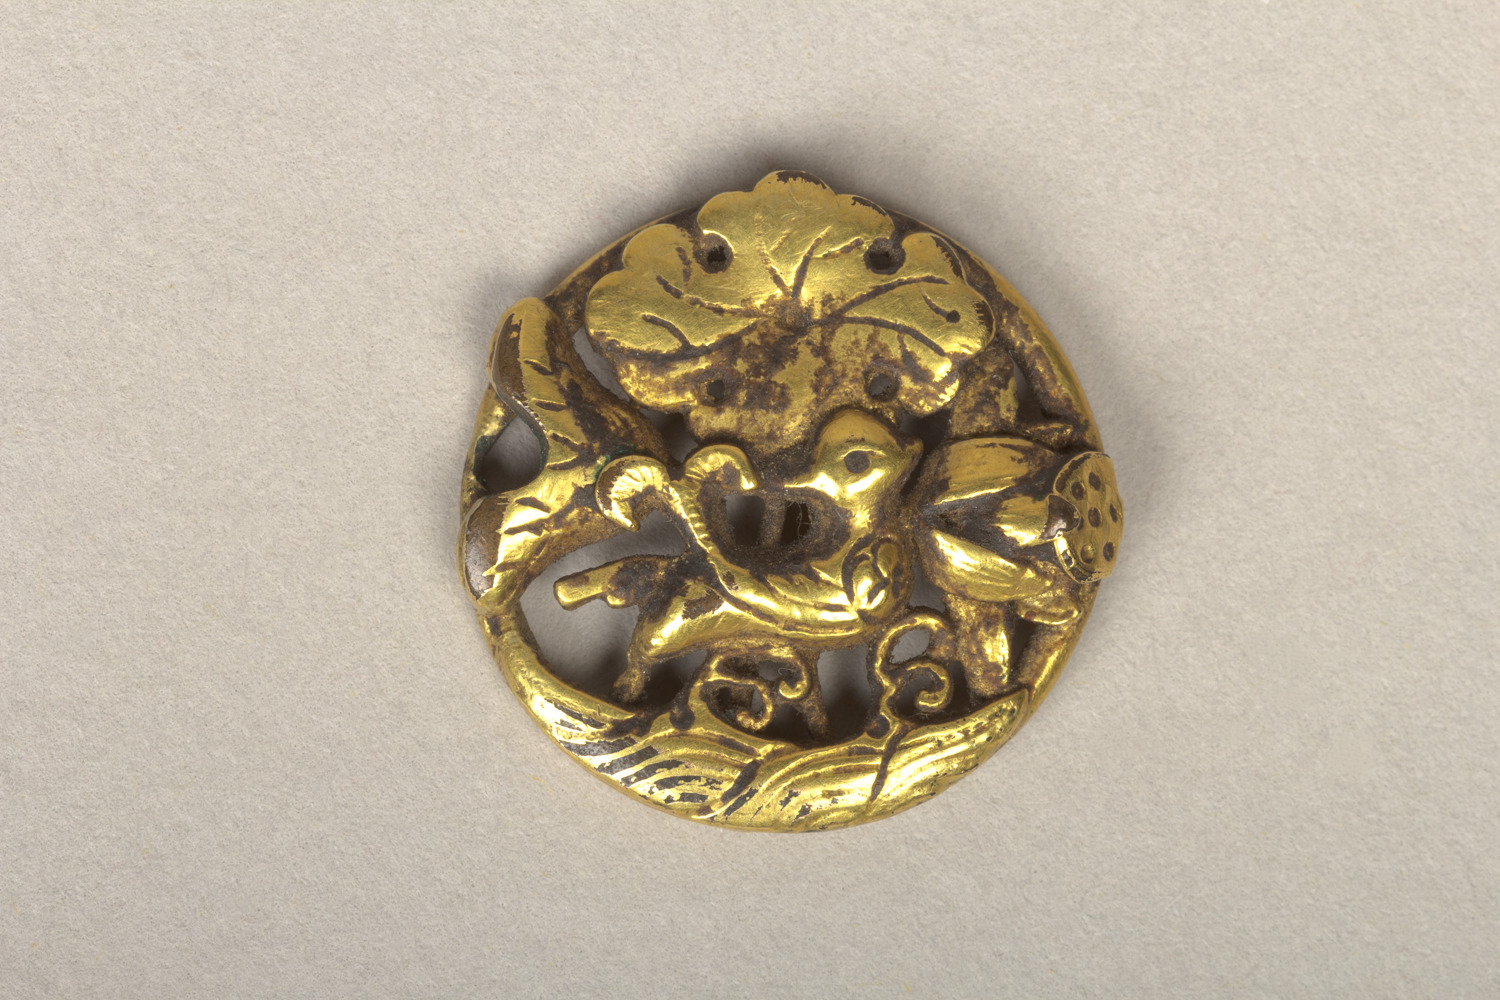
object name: ornament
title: Ornament with Decoration of Bird among Lotuses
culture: korean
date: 918-1392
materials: gold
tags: birds